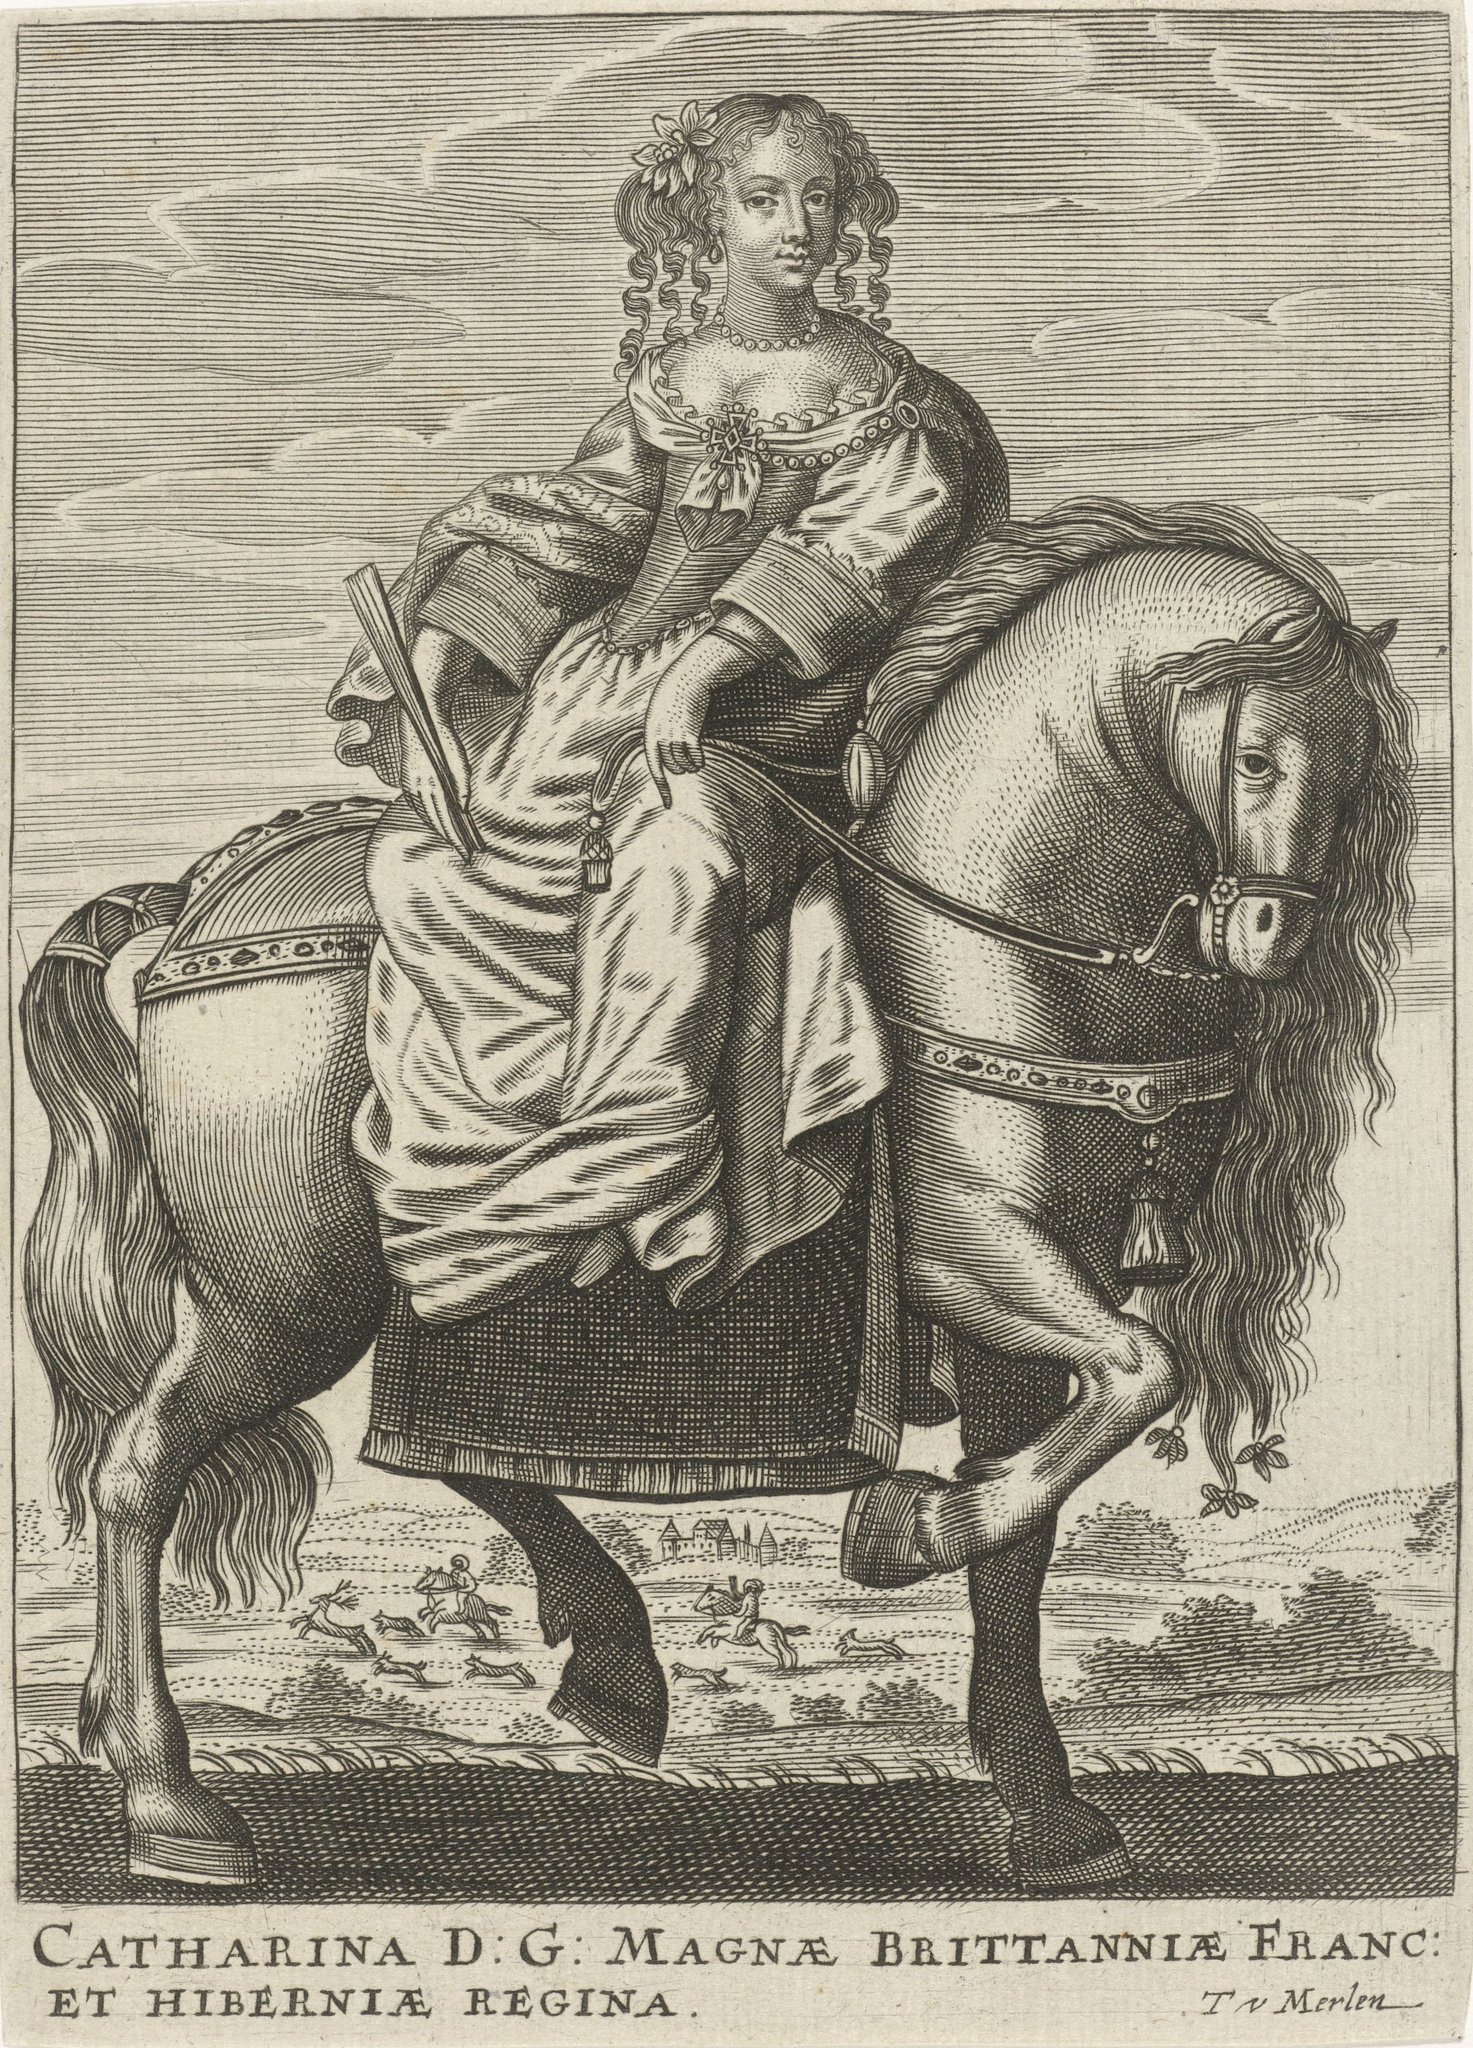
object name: print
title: Portret van Catharina van Braganza, koningin van Engeland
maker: theodor van merlen (ii)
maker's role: print maker, publisher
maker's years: 1609-1672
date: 1619-1672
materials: paper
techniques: engraving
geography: antwerp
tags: catharina van bragança, horse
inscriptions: collector's mark: Lugt 2228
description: Portret van Catharina van Braganza, koningin van Engeland, te paard met een waaier in haar hand. In het landschap een jachttafereel.